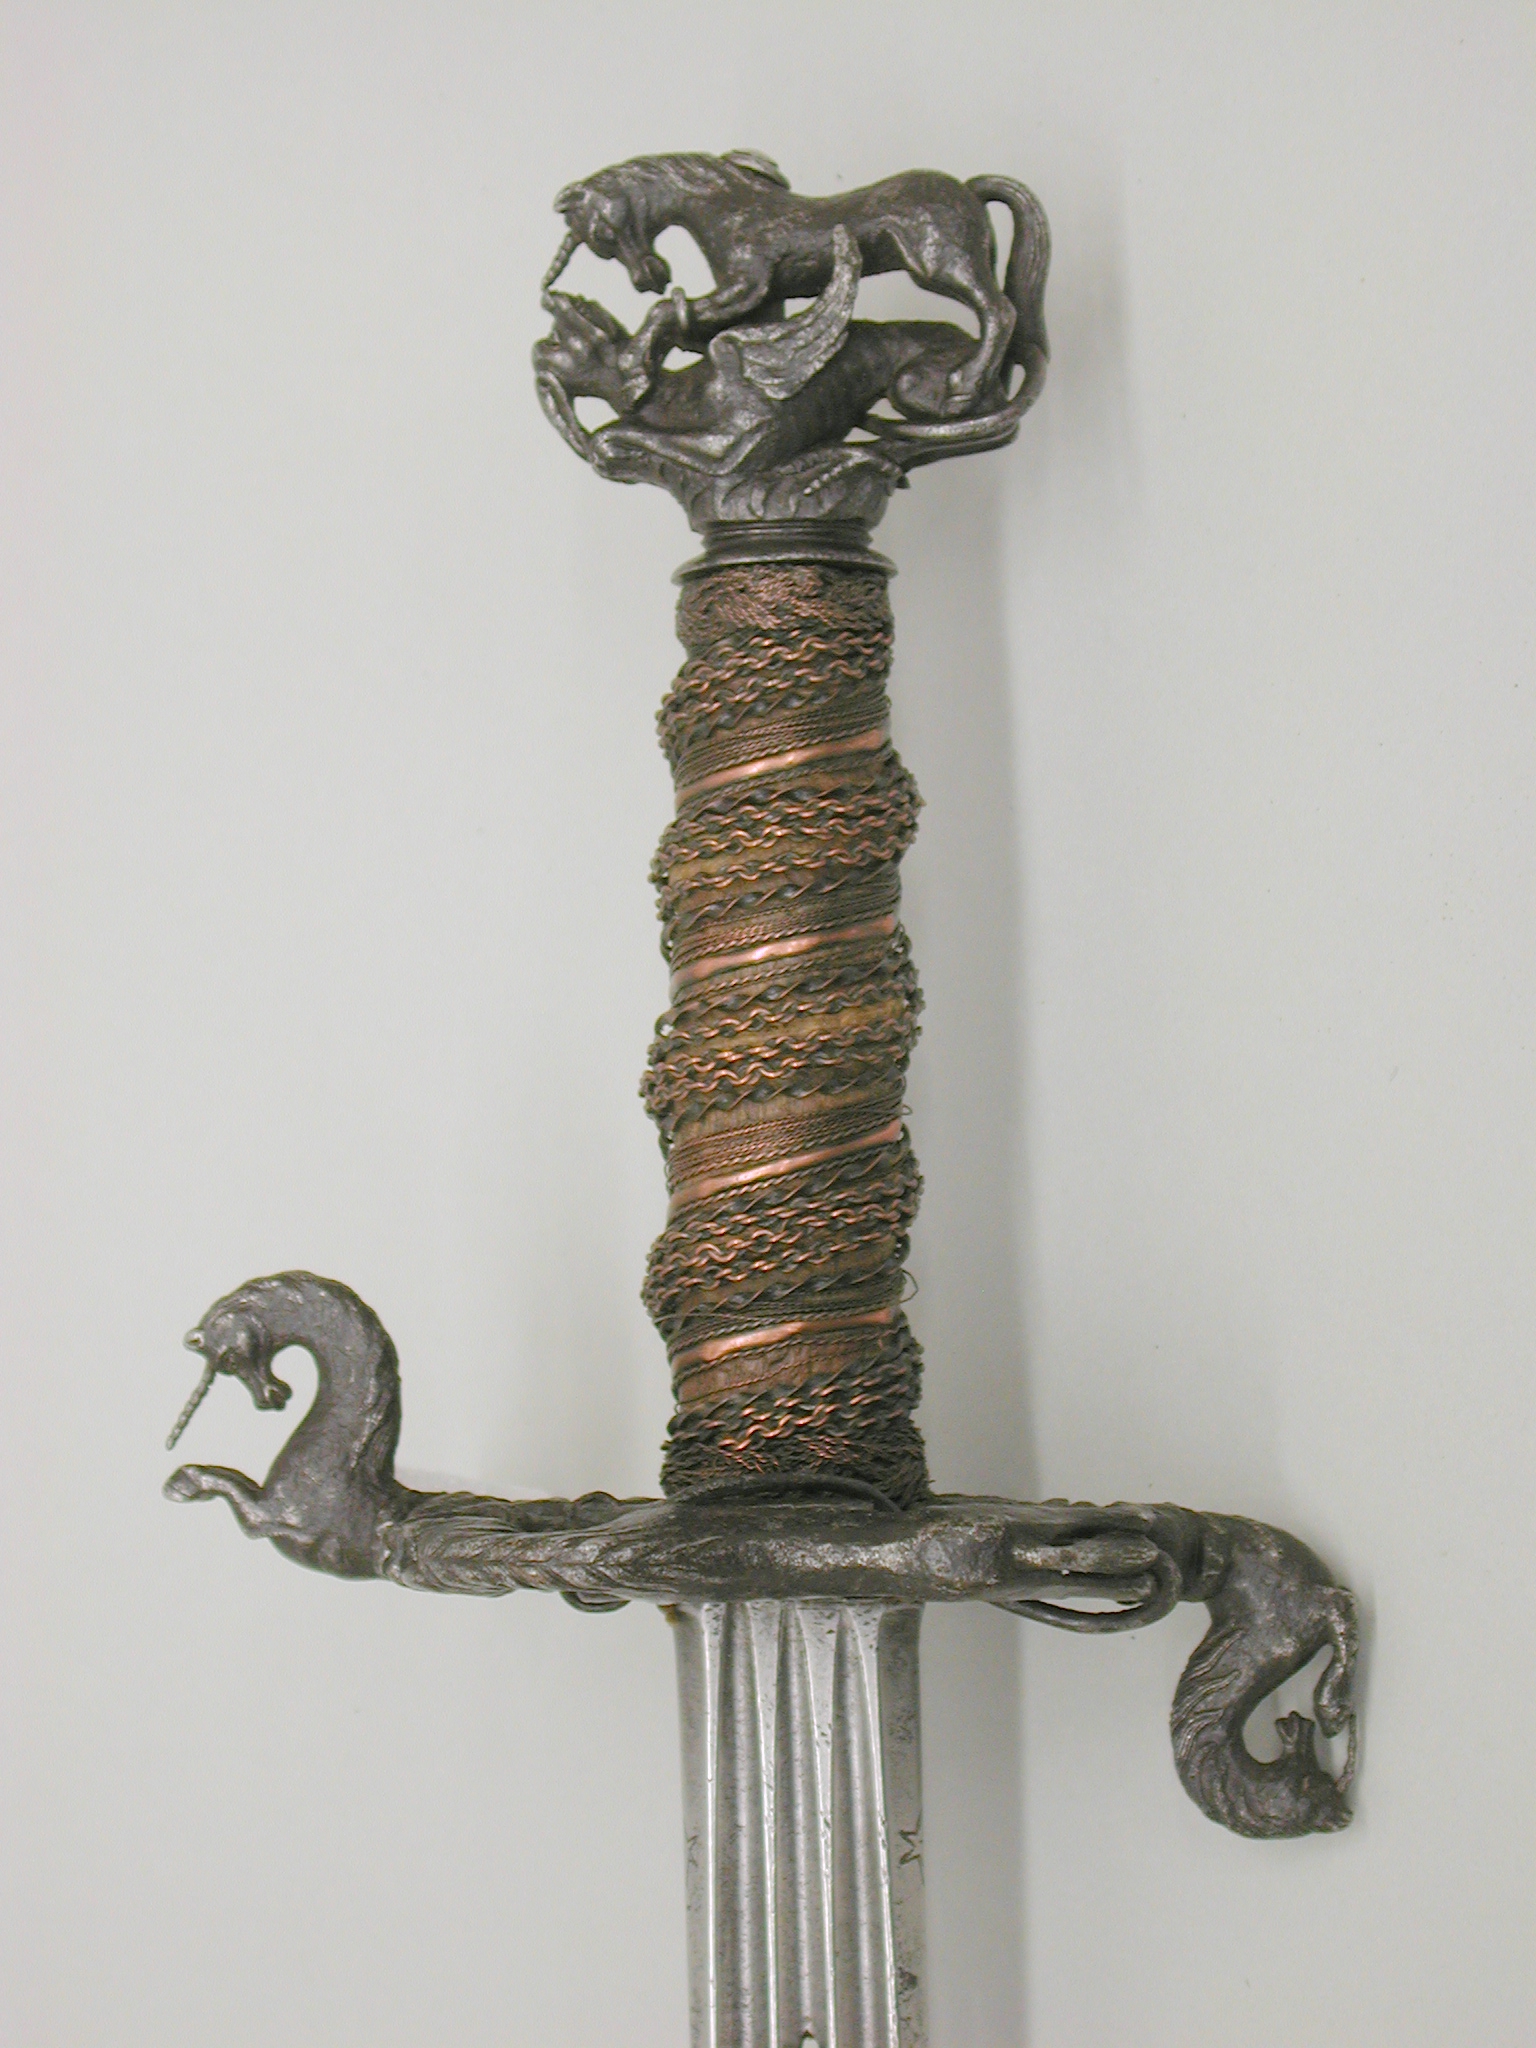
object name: smallsword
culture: dutch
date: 1650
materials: copper, leather, steel, wood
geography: netherlands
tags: unicorns